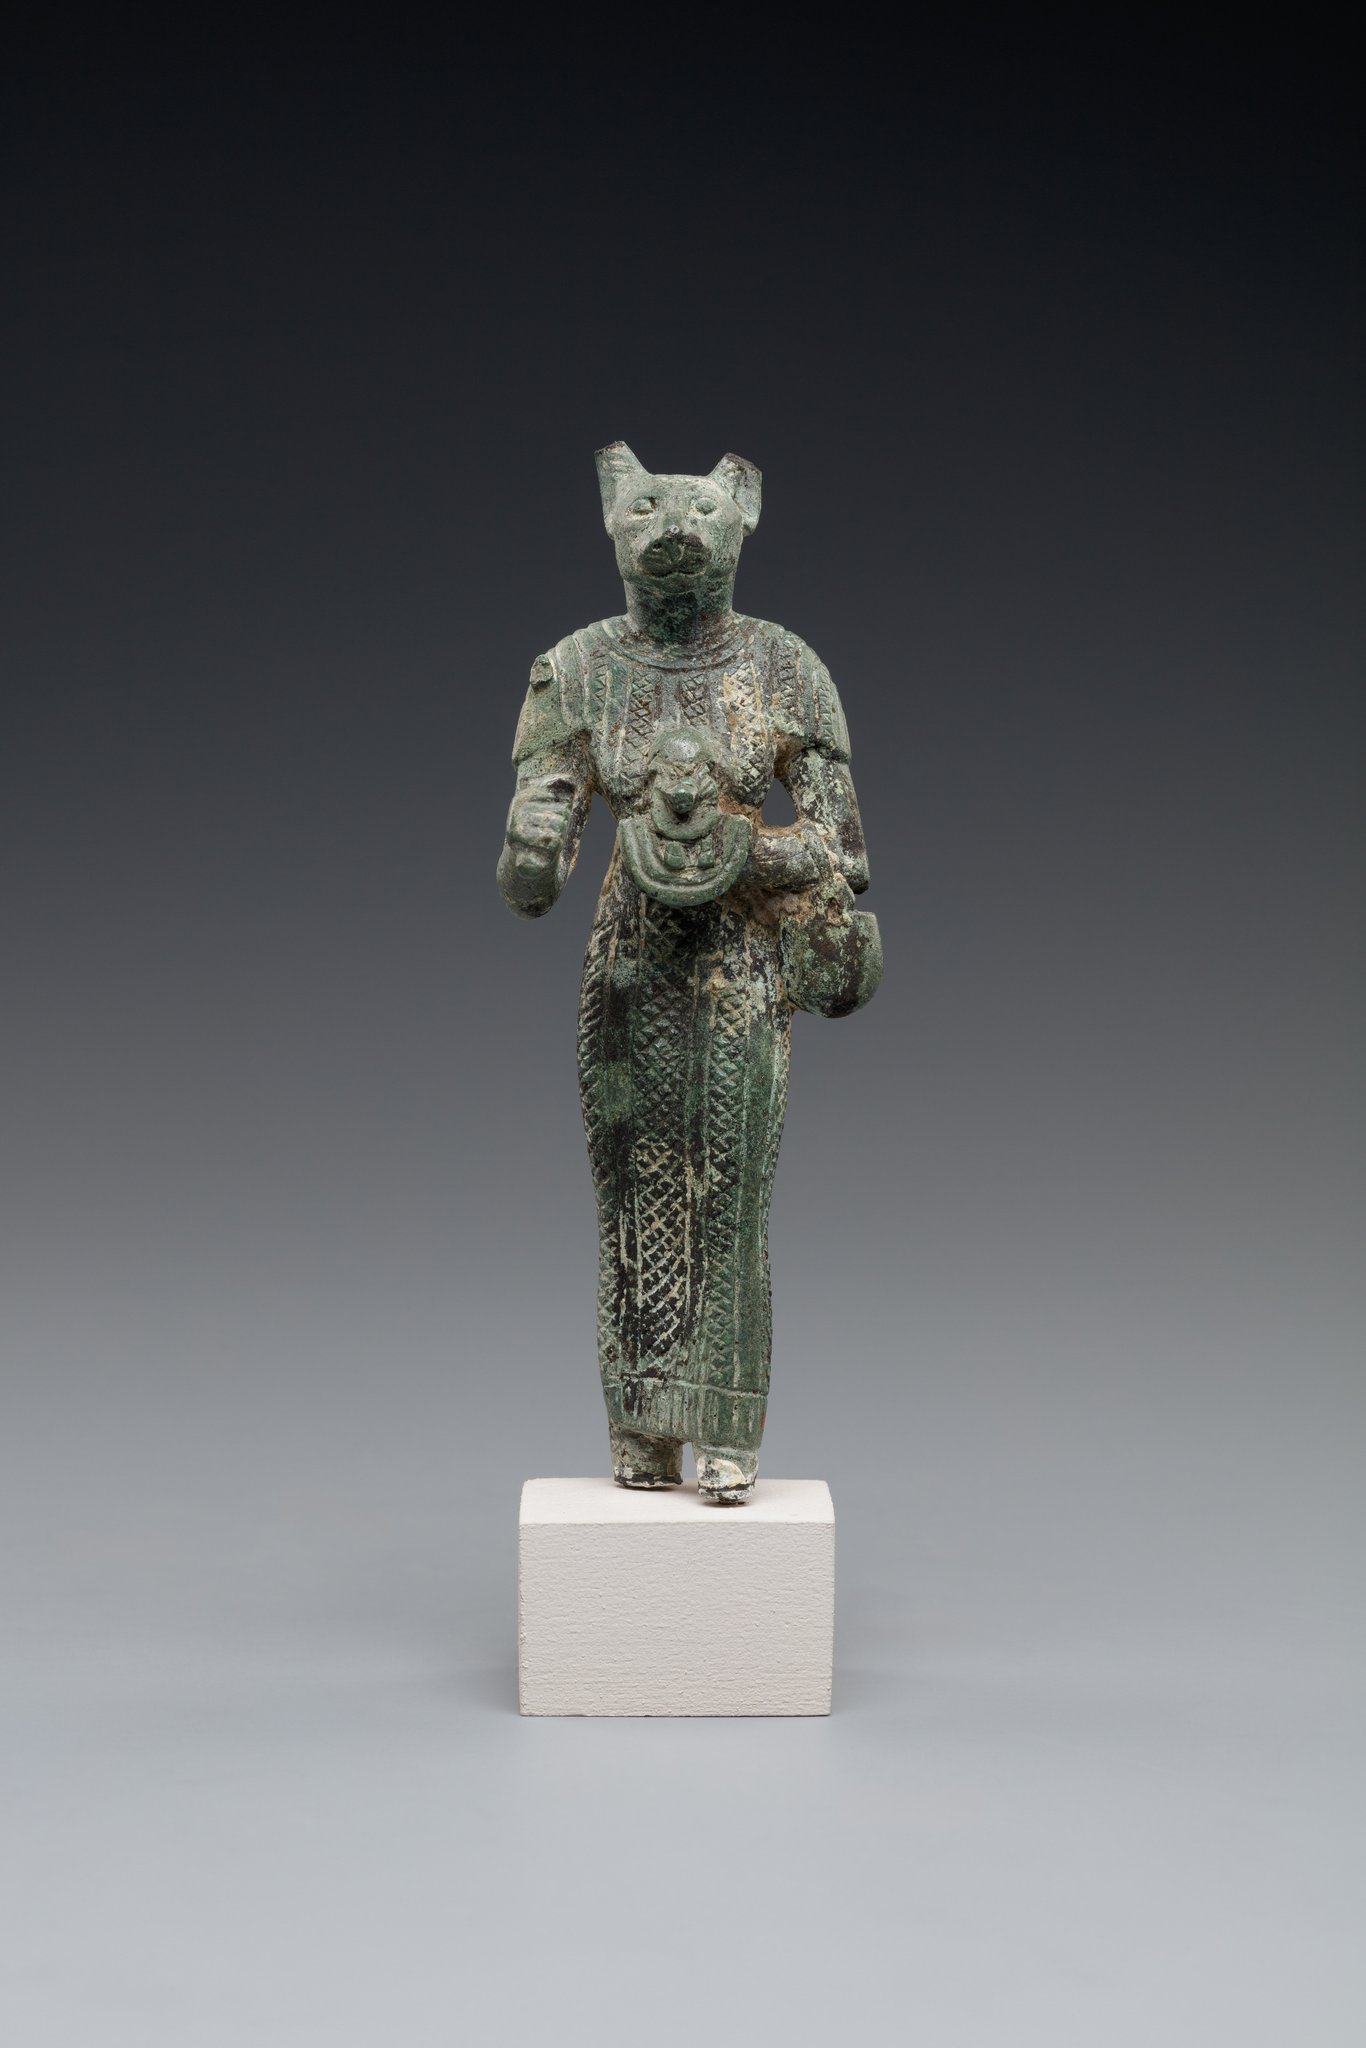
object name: statuette, bastet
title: Bastet holding a lion-headed aegis, a sistrum (broken), and a basket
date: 664-332 BCE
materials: bronze, copper alloy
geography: egypt